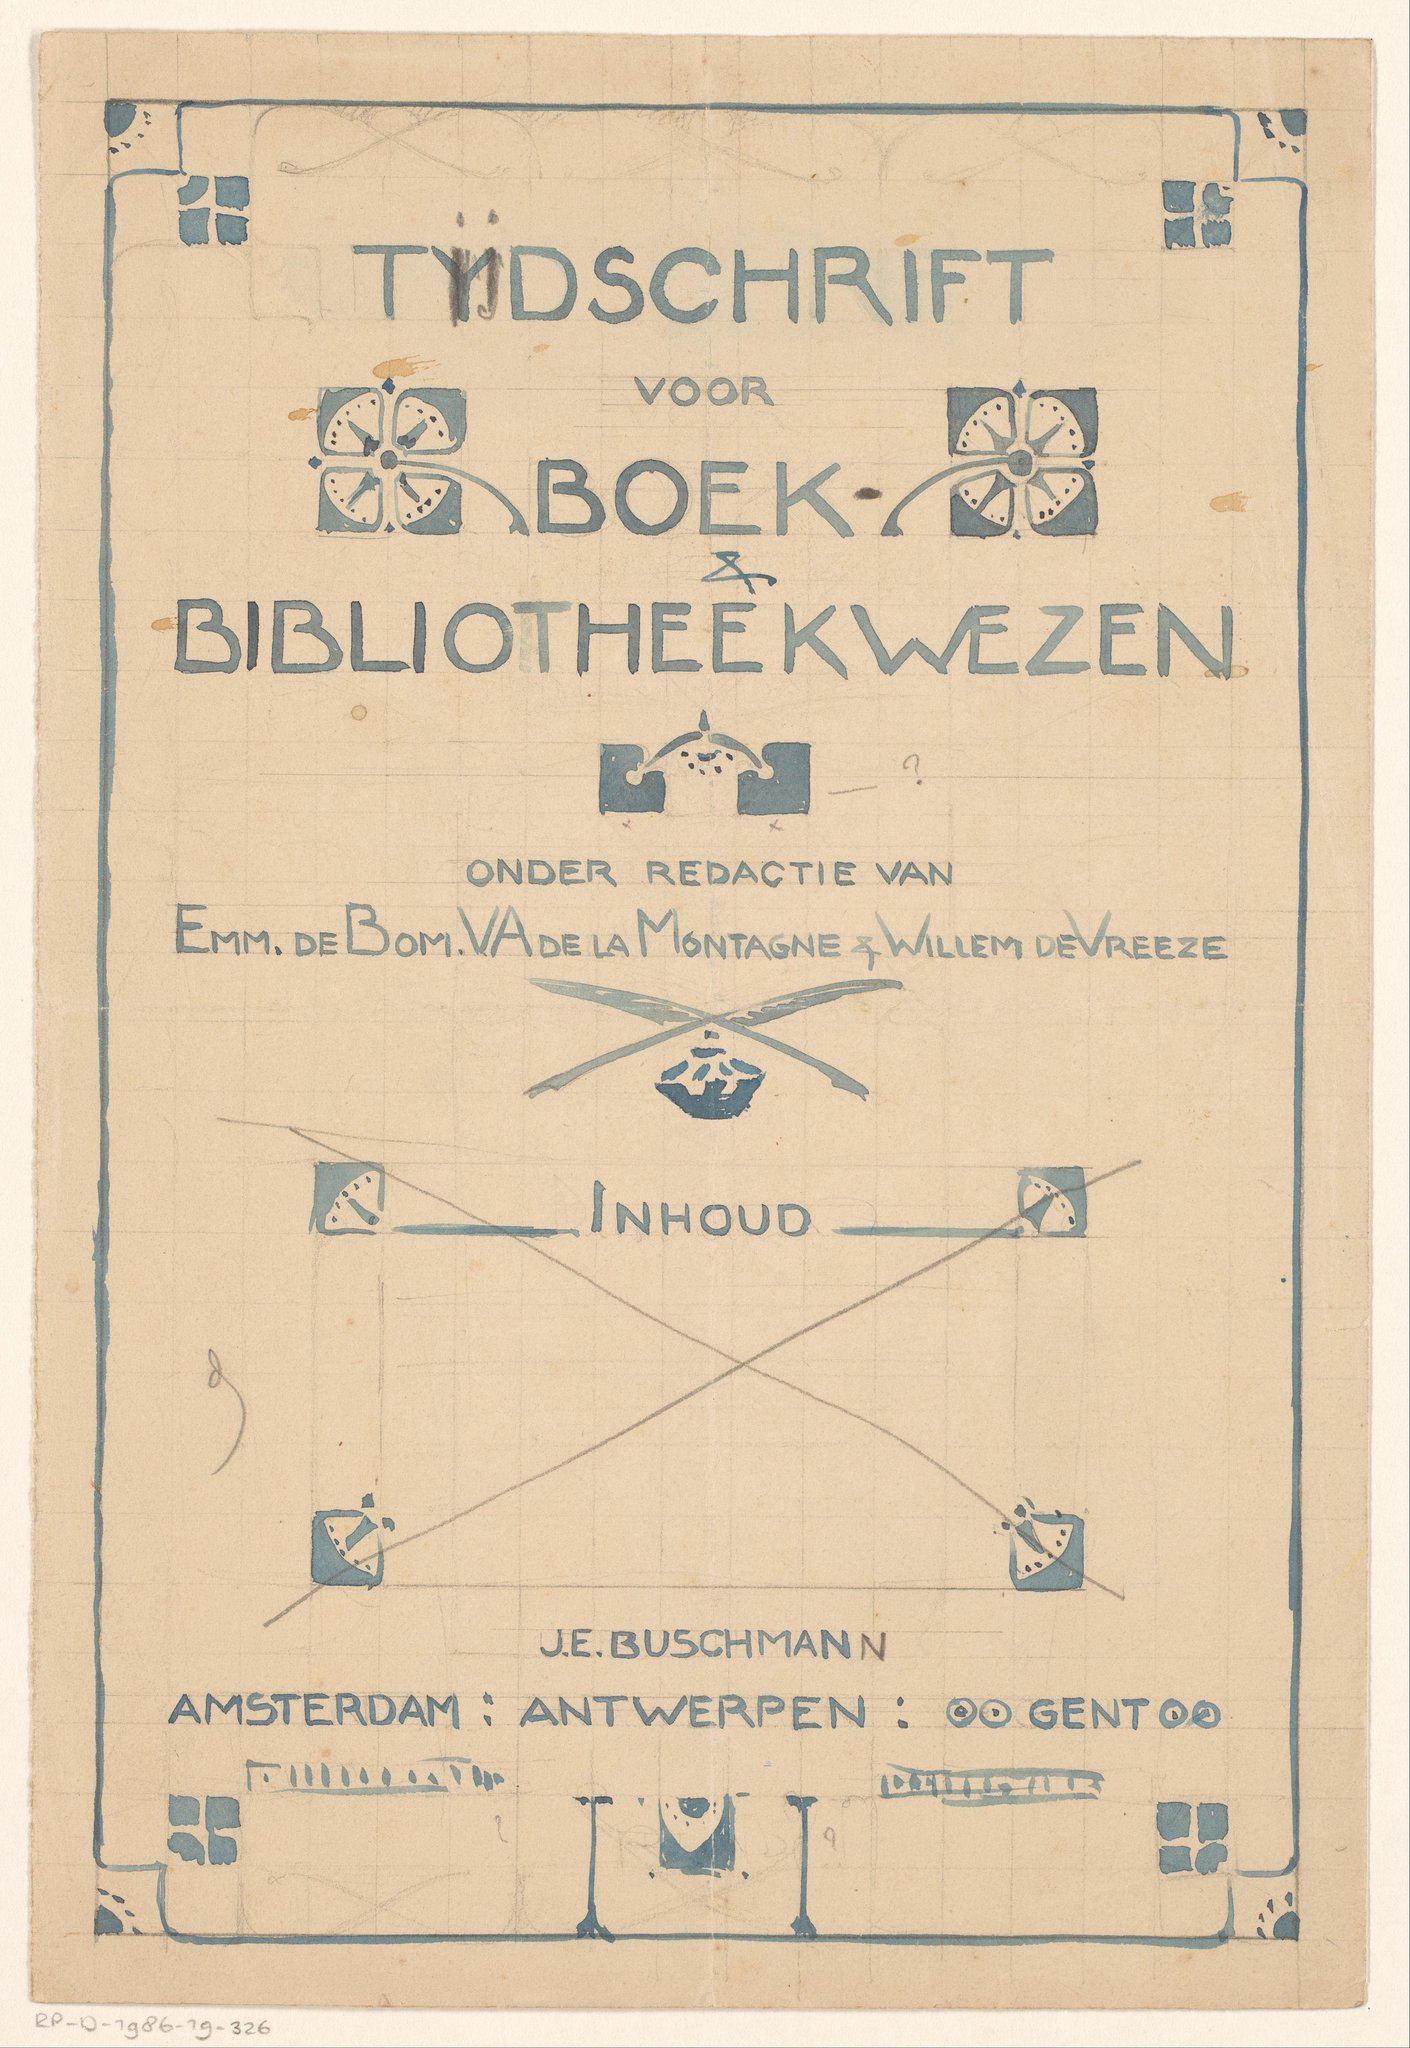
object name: drawing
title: Omslagontwerp voor: Tijdschrift voor boek- en bibliotheekwezen, 1903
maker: reinier willem petrus de vries (1874-1953)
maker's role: draughtsman, print maker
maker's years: 1874-1953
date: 1903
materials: paper, pencil, watercolor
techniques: brush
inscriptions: collector's mark: ‘R:MVS.’, number: ‘9’